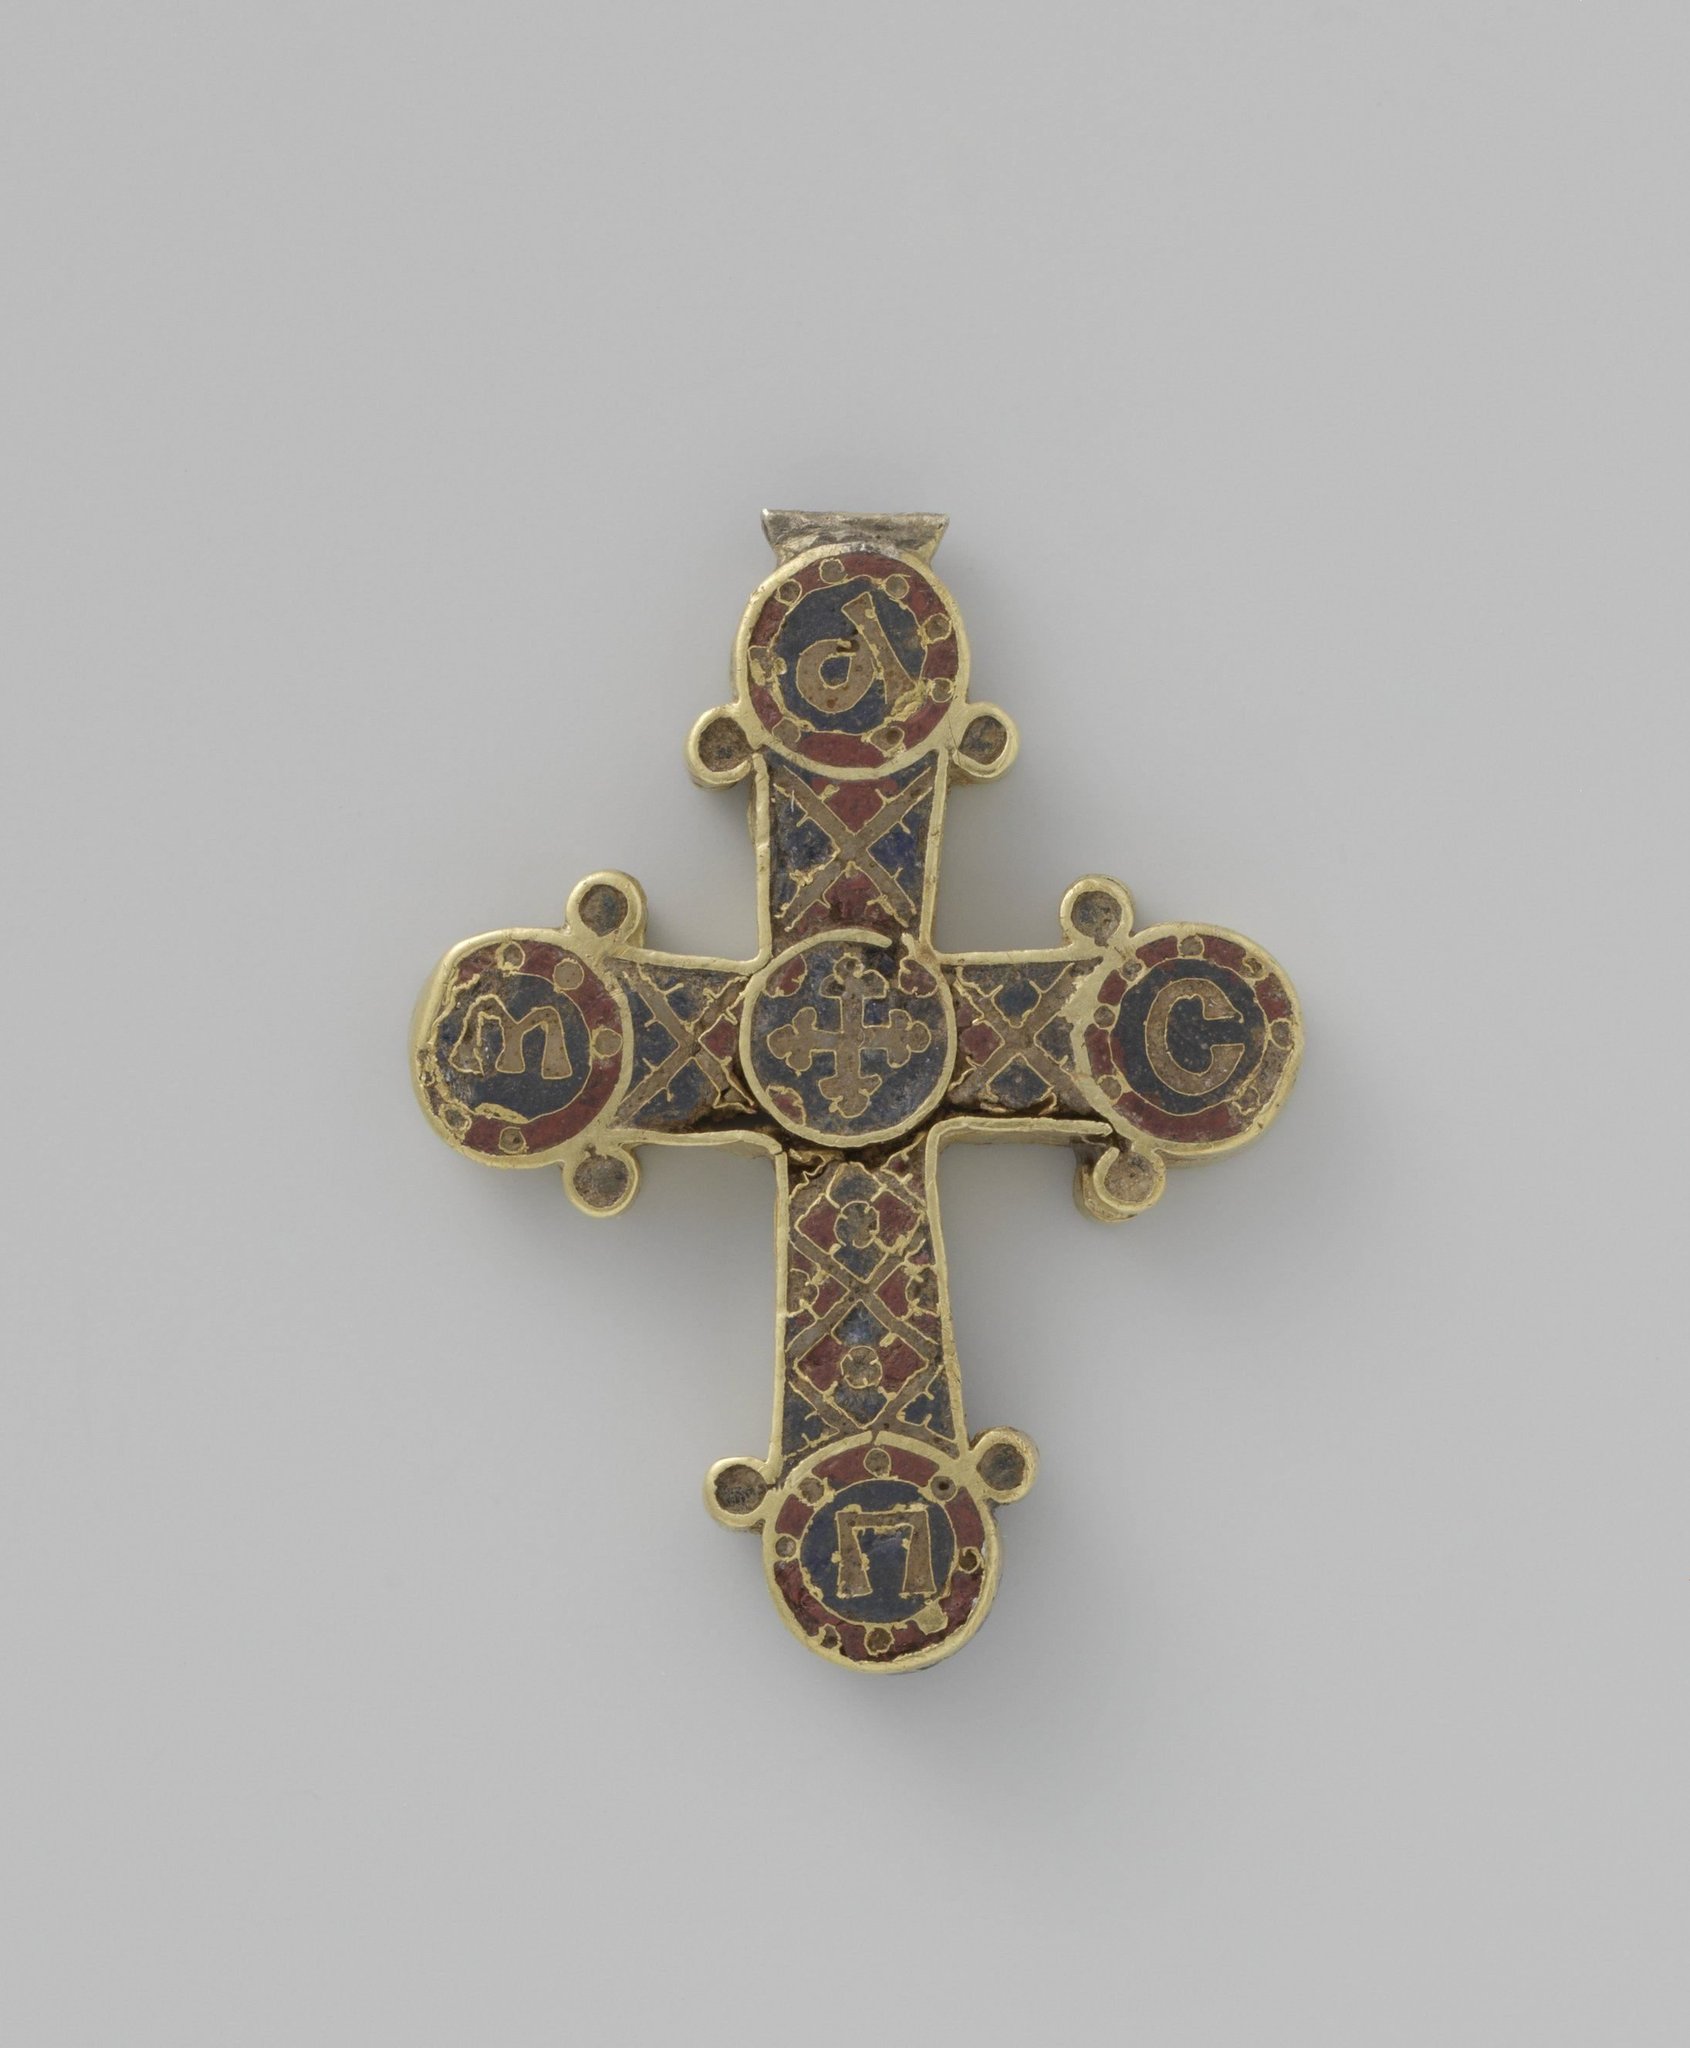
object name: pendant jewelry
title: Hanger in de vorm van een kruis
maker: Anonymous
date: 900-1100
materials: gold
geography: byzantium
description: Cross. Gold, enamel. Byzantine Empire, 10th century.